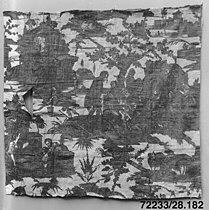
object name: furnishing textile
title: "Dites Merci"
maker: lecler, père et fils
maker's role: manufactory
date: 1798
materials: cotton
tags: human figures